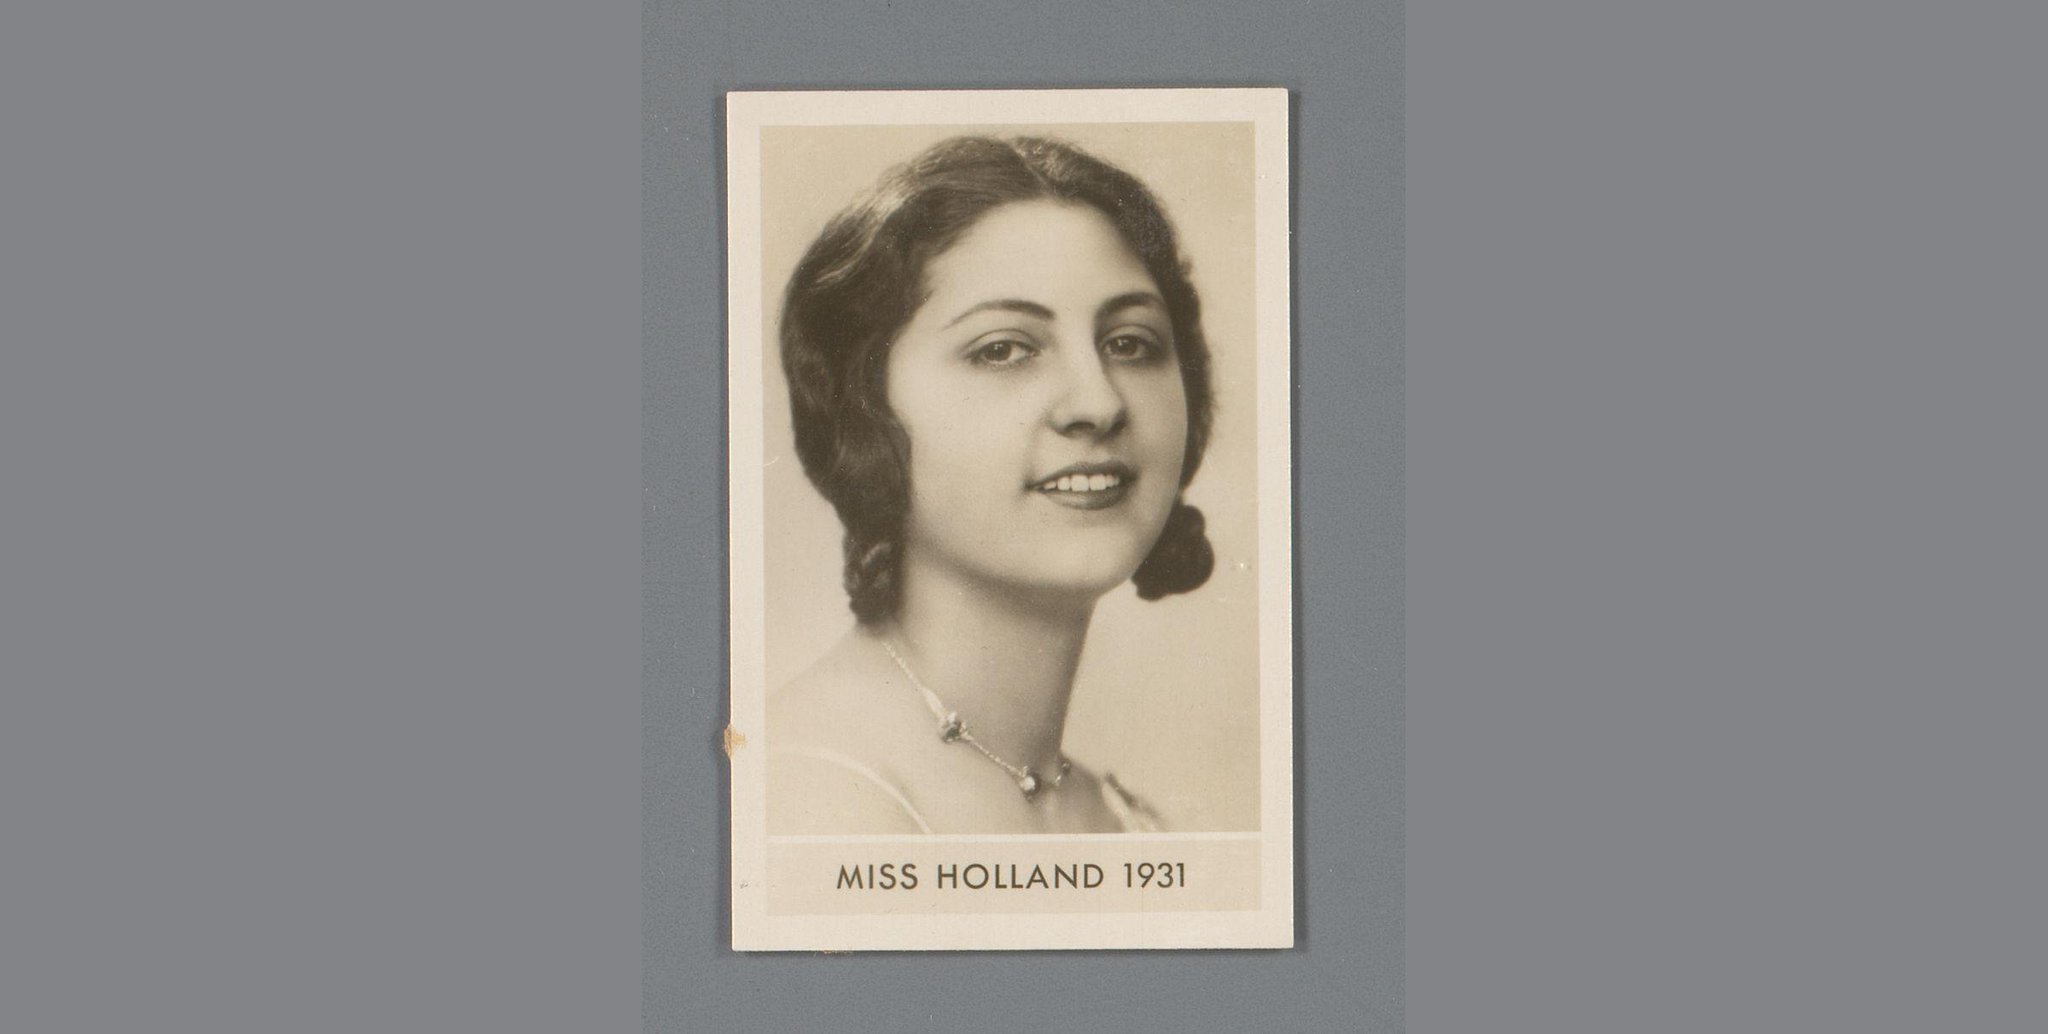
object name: photograph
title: Portret van Mary Lelyveld, Miss Nederland 1931, reclame voor Club & Liga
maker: Anonymous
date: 1931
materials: paper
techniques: gelatin silver print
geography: dresden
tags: historical persons - bb - woman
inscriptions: inscription: ‘Die schönsten/ Frauen der Welt/ dargestellt durch die Schön-/ heitsköniginnen aller Länder,/ finden Sie in 190 echten/ Bromsilber-Fotos, die nur den/ CLUB-und-LIGA-Packun-/ gen beiliegen. Eind prächtiges/ Sammel-Album erhalten Sie/ für 75 Pfennig vom Händler/ oder bei Einsendung von/ 75 Pfennig in Briefmarken/ von der Bilderstelle Lohse,/ Dresden A24, Nossener Str. 1./ Ges. gesch. Nachdruck verboten!’